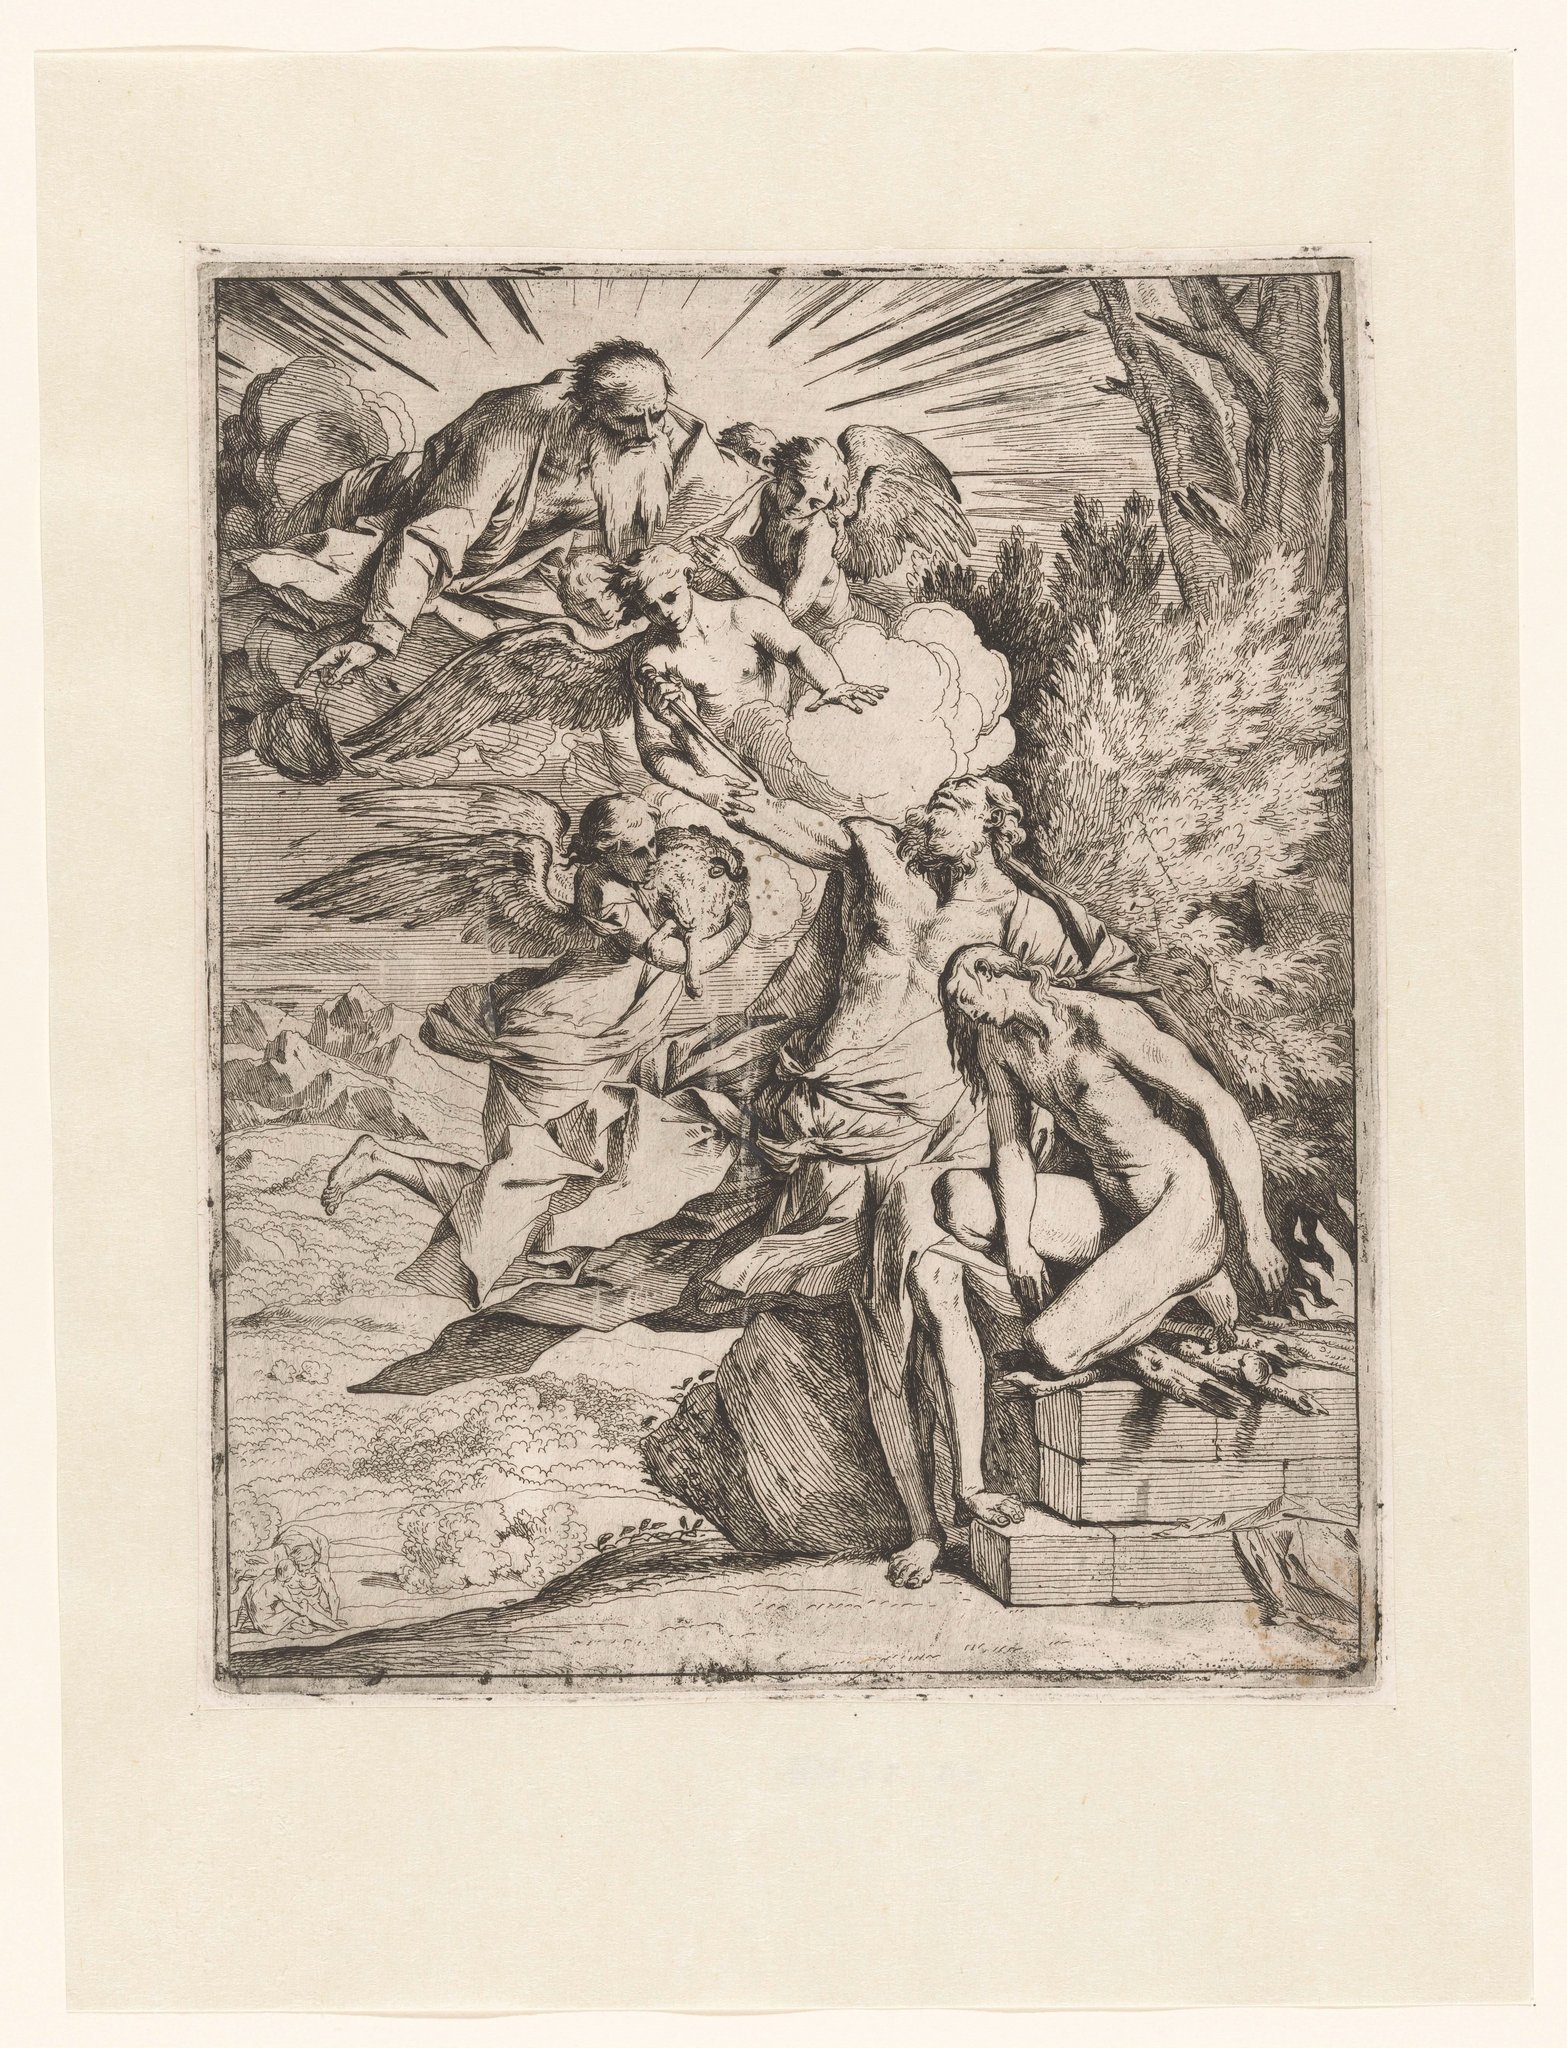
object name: print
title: Offer van Isaak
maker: pietro testa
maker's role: draughtsman, painter, print maker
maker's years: 1611-1650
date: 1645-1650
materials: paper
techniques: etching, intaglio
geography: italy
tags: ram, when abraham has his hand raised to kill isaac, an angel restrains abraham's hand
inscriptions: collector's mark: Lugt 240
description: Rechts Abraham met een mes in de hand, op het punt staand om zijn zoon Isaak te offeren. Linksboven God omringd door engelen, waarvan er één de hand van Abraham tegenhoudt. Naast Abraham een engel met de ram die Abraham offerde in plaats van Isaak.